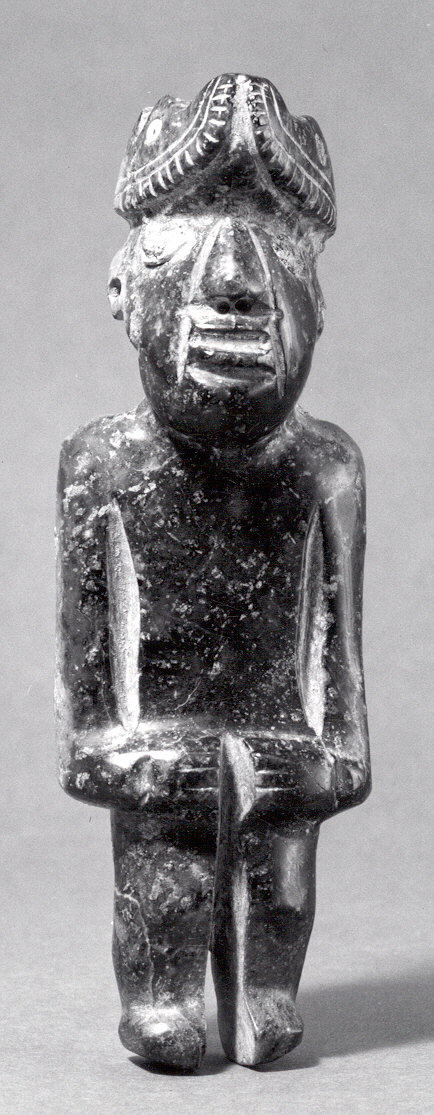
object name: male figure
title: Figure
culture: mezcala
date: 1-800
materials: stone, shell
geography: mexico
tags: men